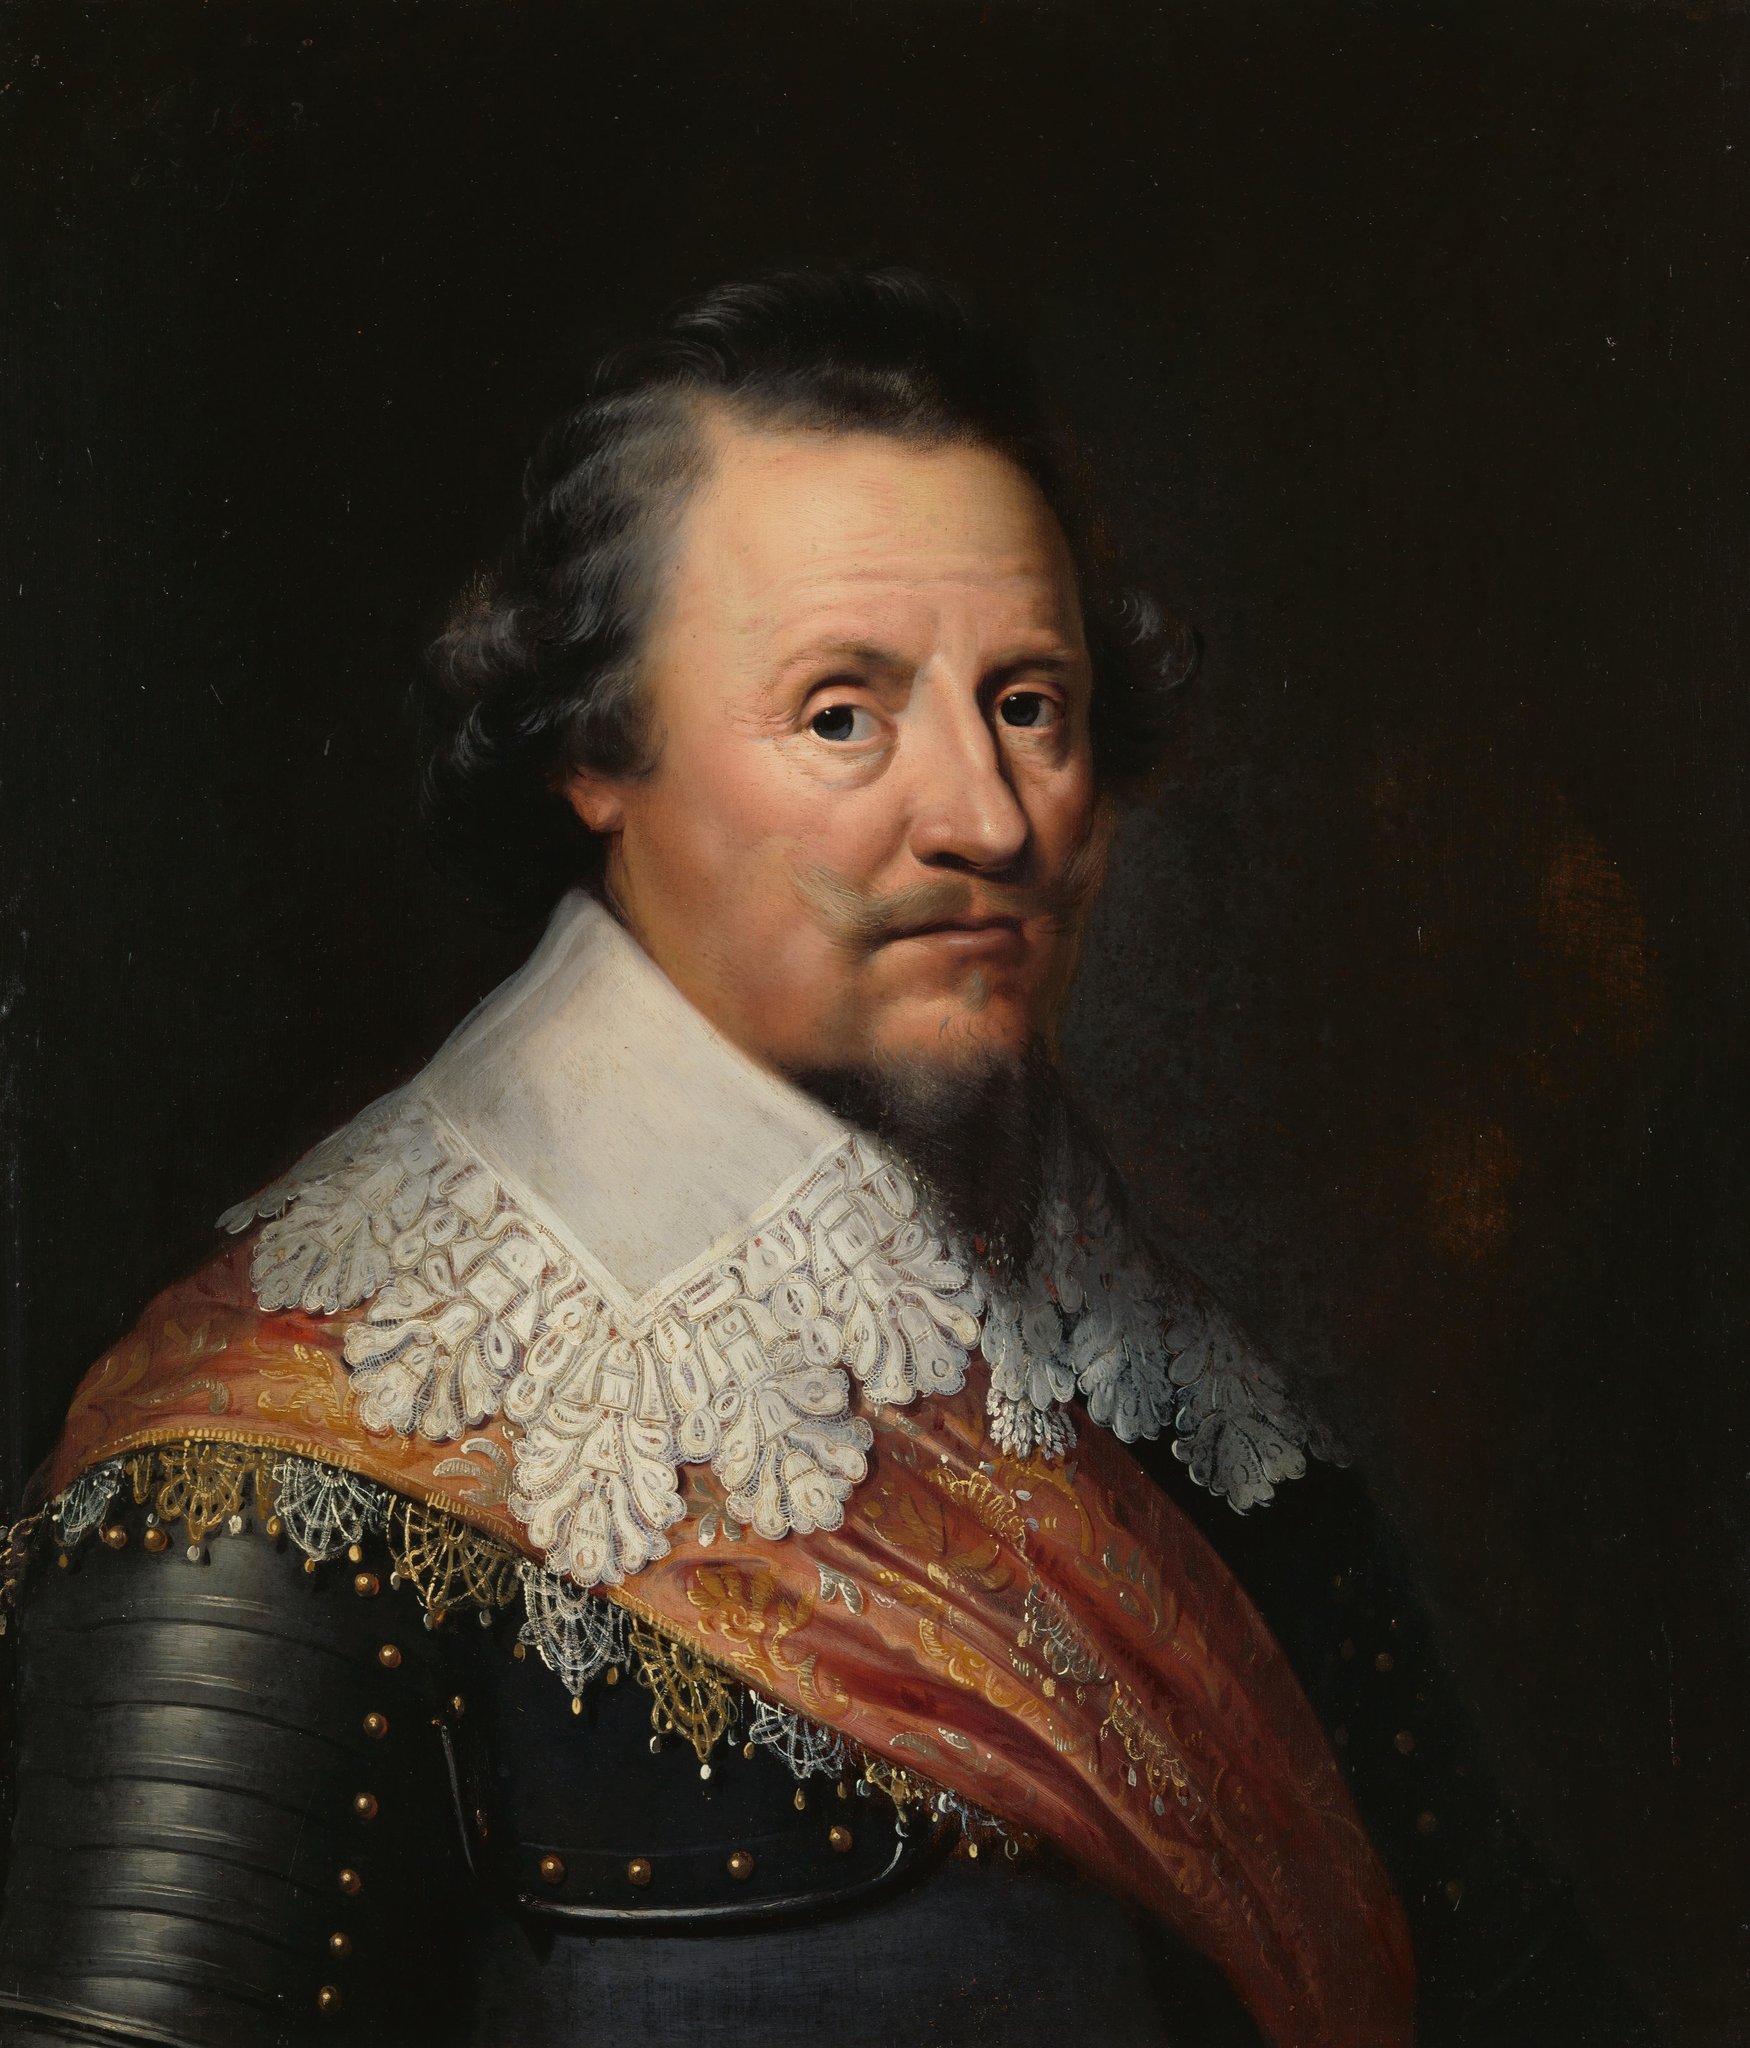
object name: painting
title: Ernst Casimir (1573-1632), Count of Nassau-Dietz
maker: wybrand de geest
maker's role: draughtsman, painter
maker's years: 1592-1665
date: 1633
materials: oil, panel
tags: ernst casimir graaf van nassau-dietz, historical persons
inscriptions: signature and date, upper left: ‘Ao. 1633. / VDG. ƒ.’, coat of arms, on the reverse: wax seal containing, among other devices, a four-legged animal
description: Portret van Ernst Casimir, graaf van Nassau-Dietz, stadhouder van Friesland, Groningen en Drente. Buste, naar rechts. Pendant van SK-A-572.